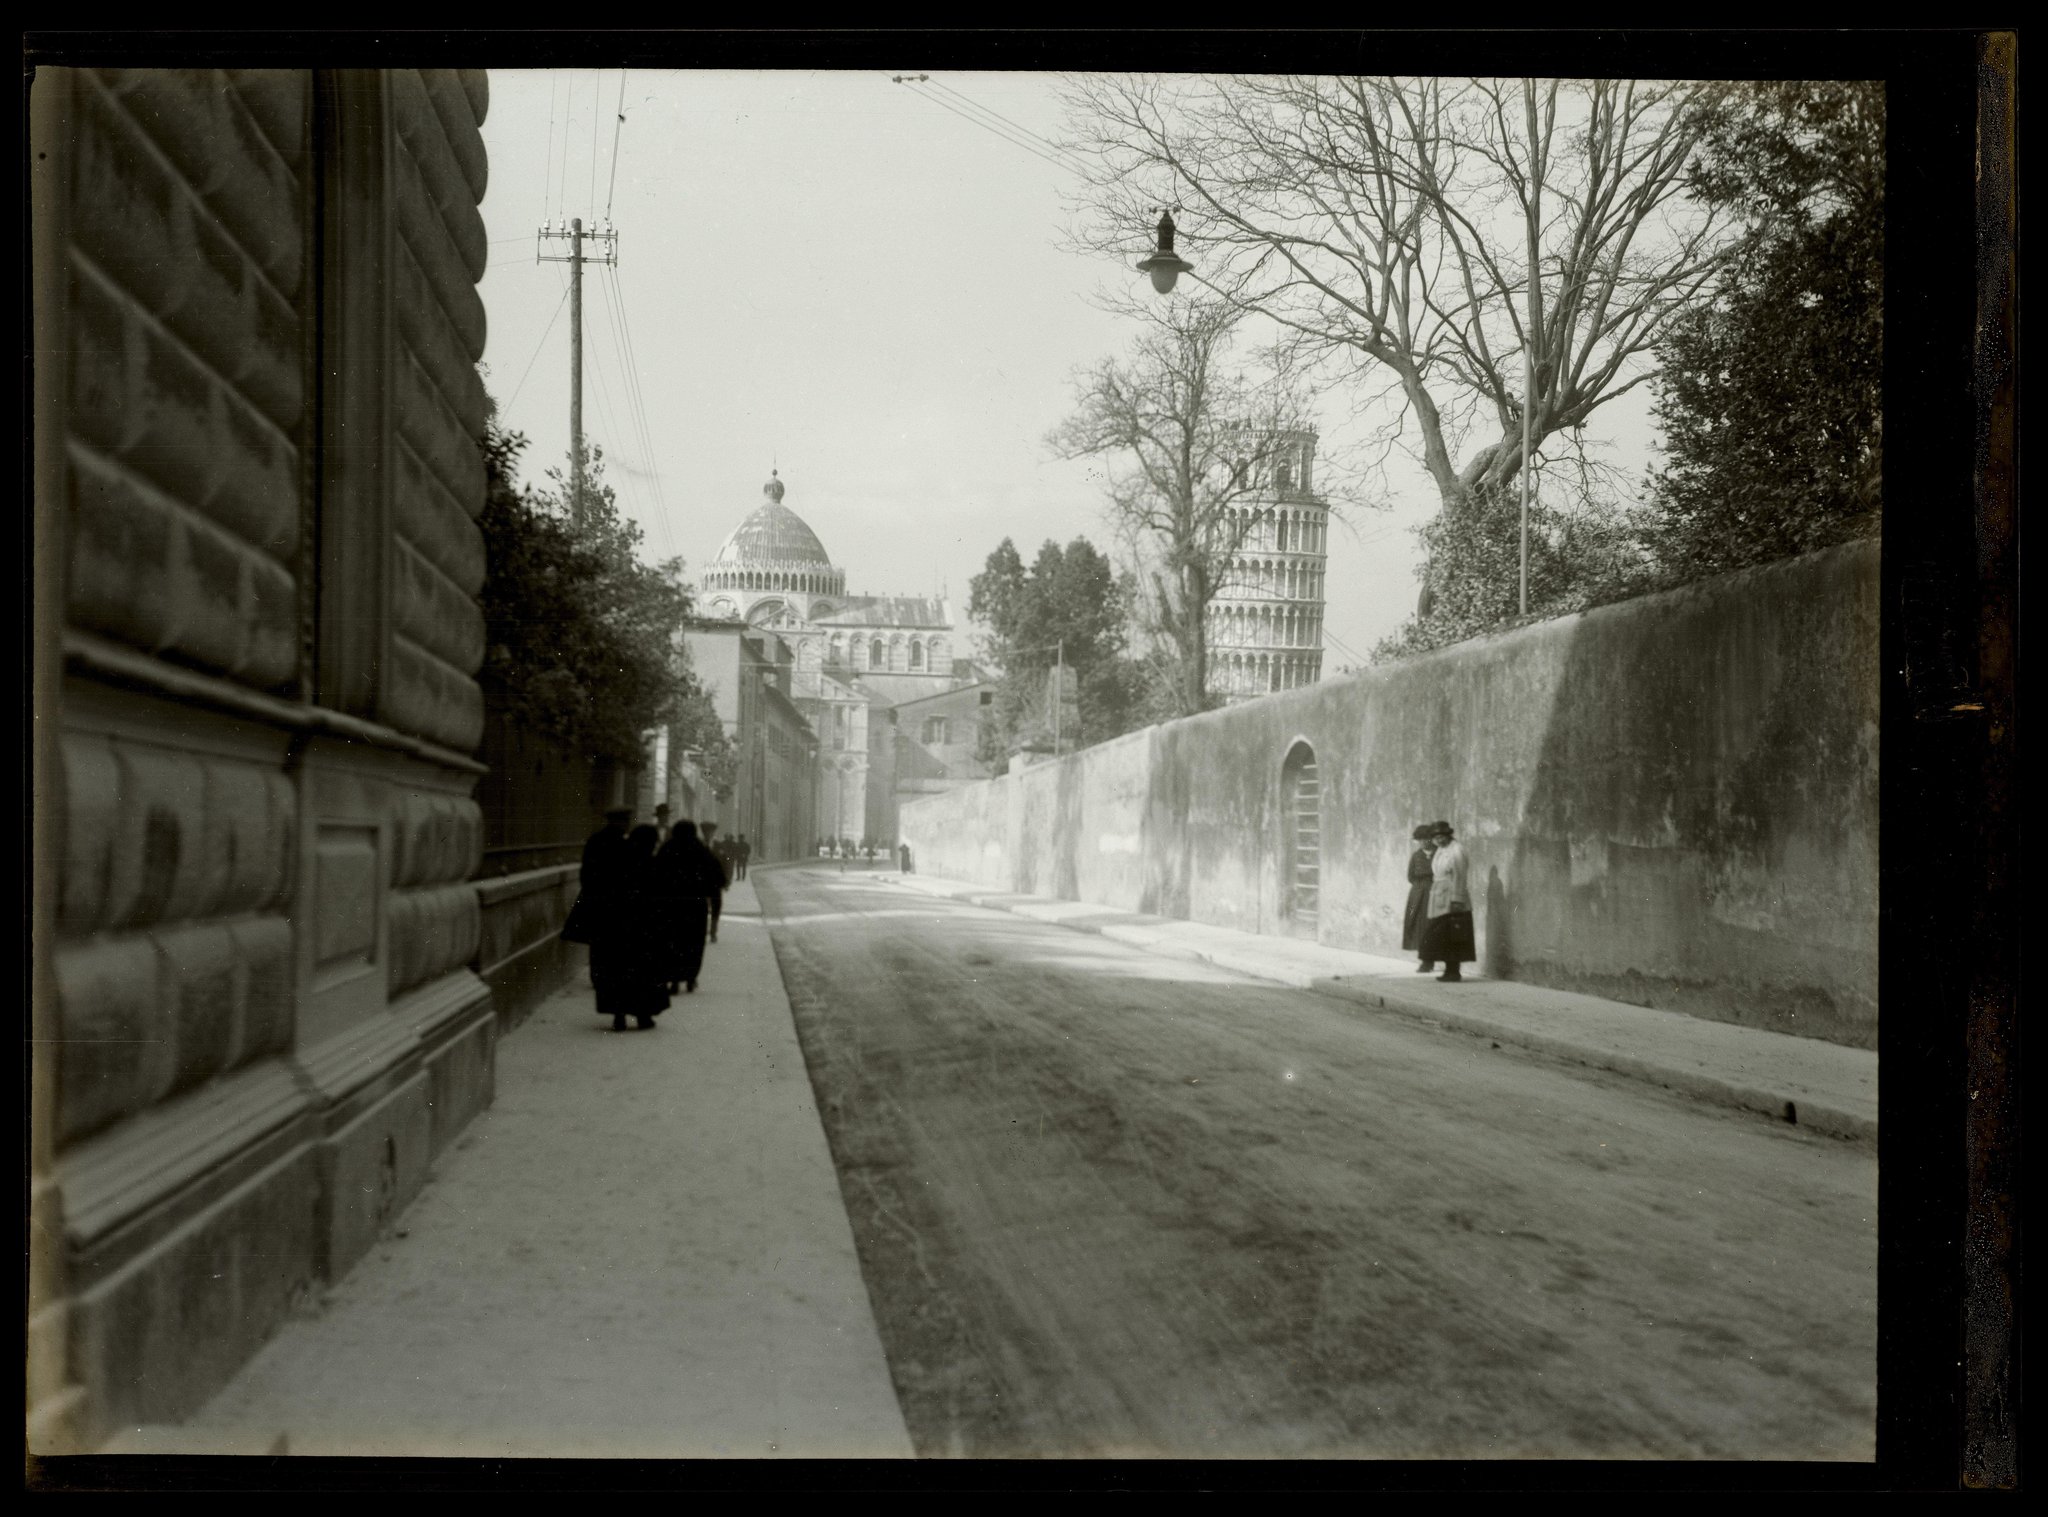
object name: negative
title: Filmnegatief met opname van Genua, Pisa, Ravenna of Milaan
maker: Anonymous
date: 1907-1935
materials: film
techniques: gelatin silver negative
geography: italy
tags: italy